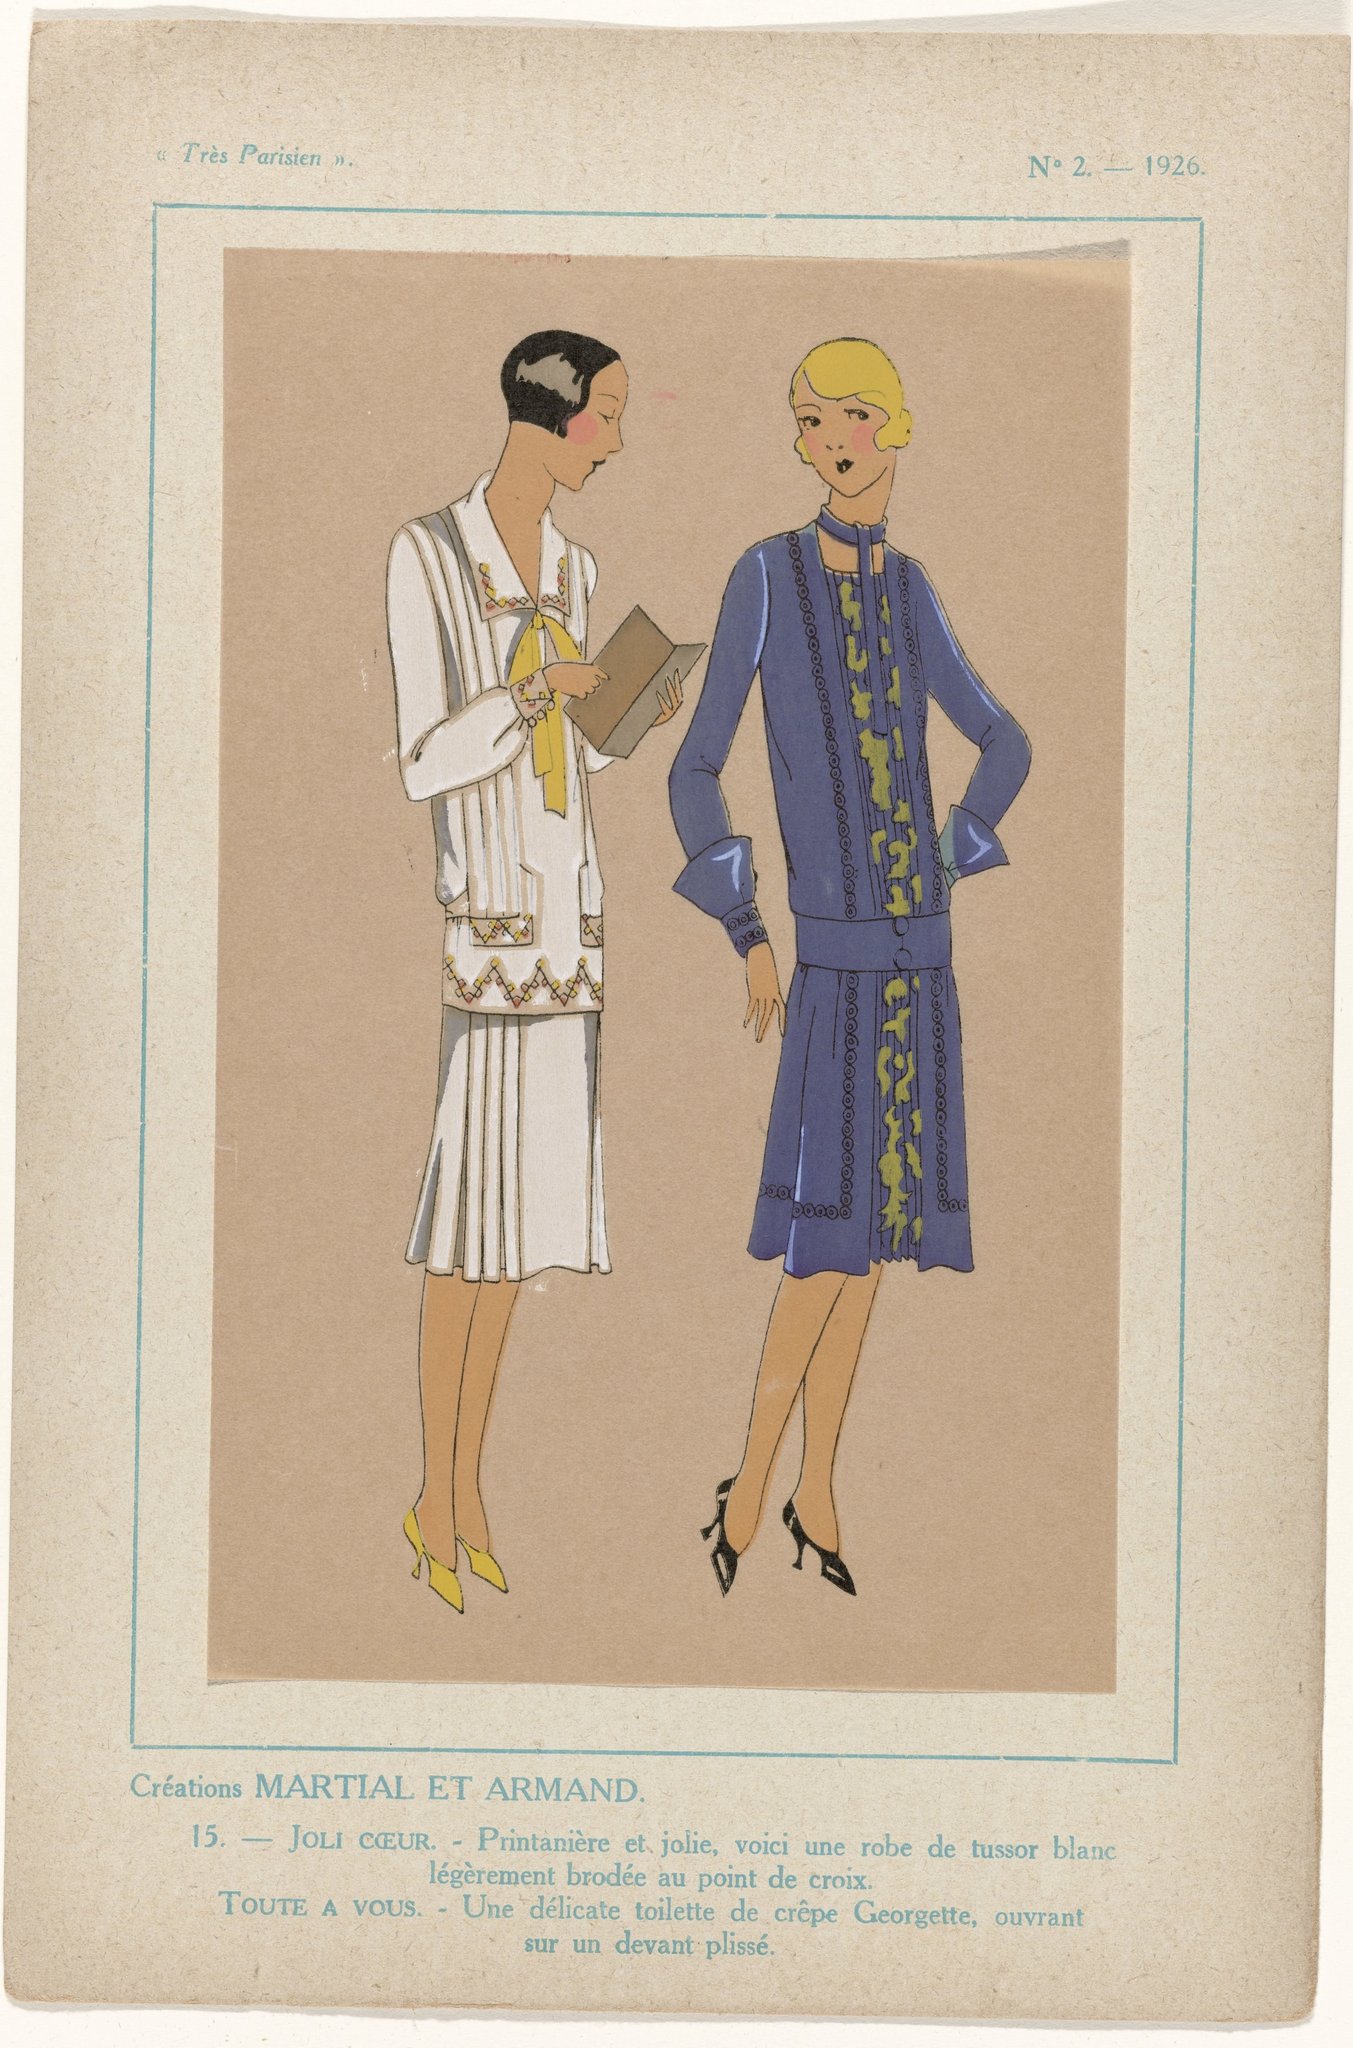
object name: fashion print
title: Très Parisien, 1926, No. 2, Pl. 15: Créations MARTIAL ET ARMAND - JOLI COEUR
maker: g-p. joumard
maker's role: publisher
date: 1926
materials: paper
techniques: hand coloring, letterpress printing, lithography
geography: paris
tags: dress, gown: day dress (+ women's clothes), fashion plates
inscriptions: caption: ‘15. - JOLI COEUR. - Printanière et jolie, voici une robe de tussor blanc légèrement brodée aux points de croix. TOUTE A VOUS. Une délicate toilette de crêpe Georgette, ouvrant sur un devant plissé.’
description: Twee japonnen van Martial et Armand. Prent uit het modetijdschrift Très Parisien... La Mode, Le Chic, L'Élegance (1920-1936)